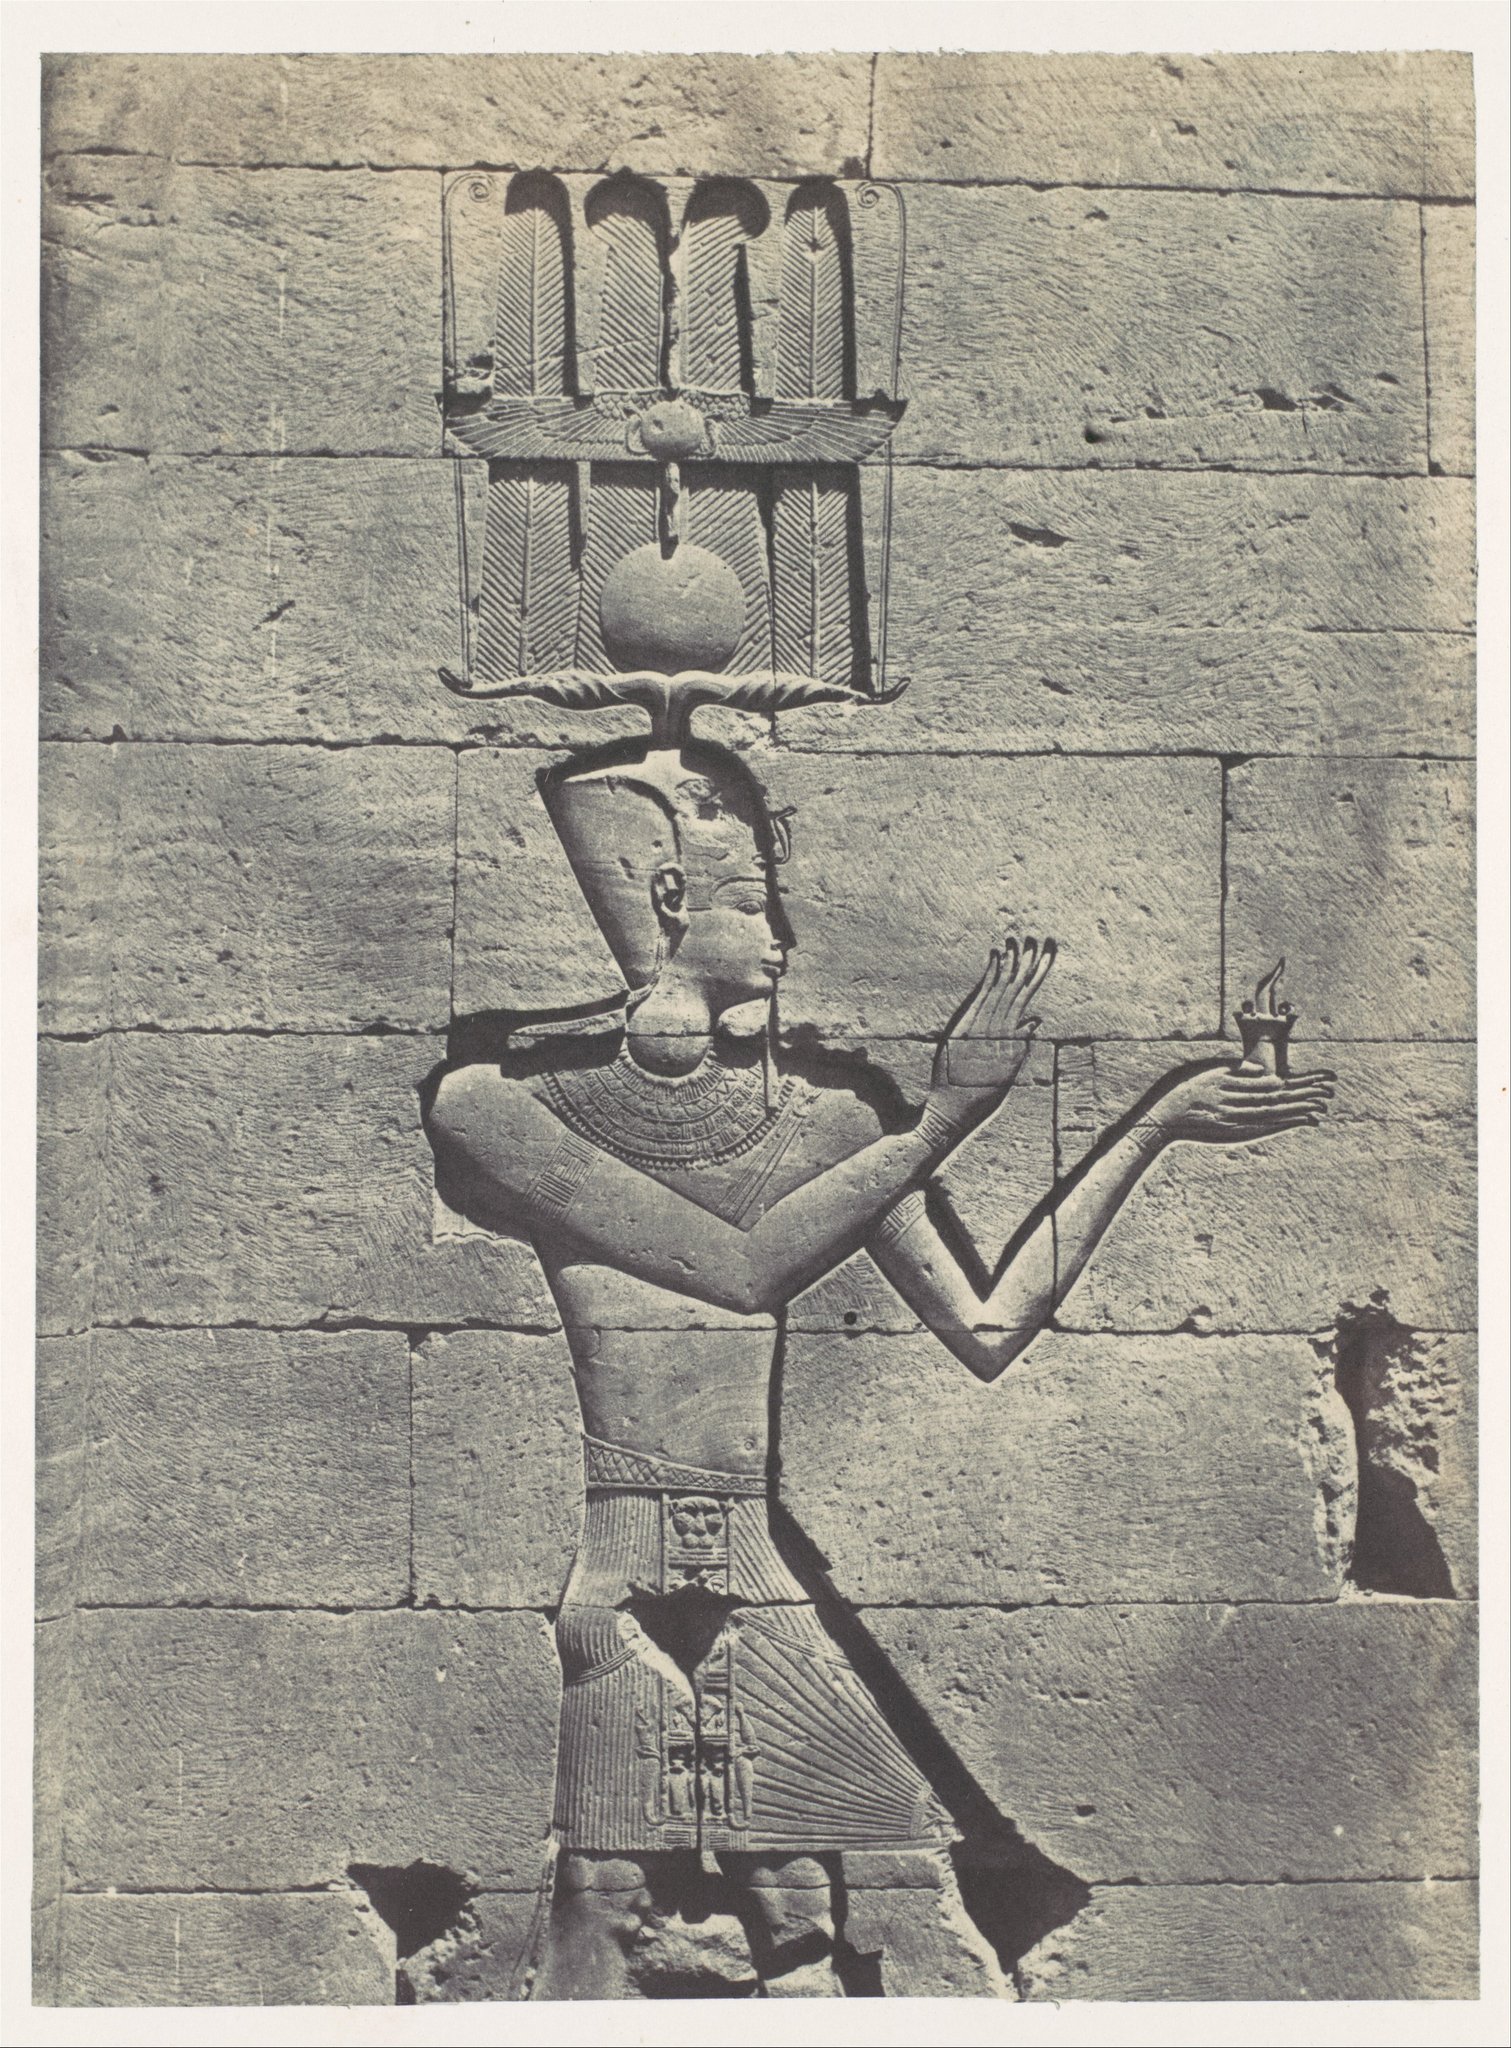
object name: photograph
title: Nubie. Kalabscheh. Sculptures de la Facade postérieure du Temple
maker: maxime du camp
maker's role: artist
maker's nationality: french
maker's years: 1822-1894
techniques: paper negative, salted paper print